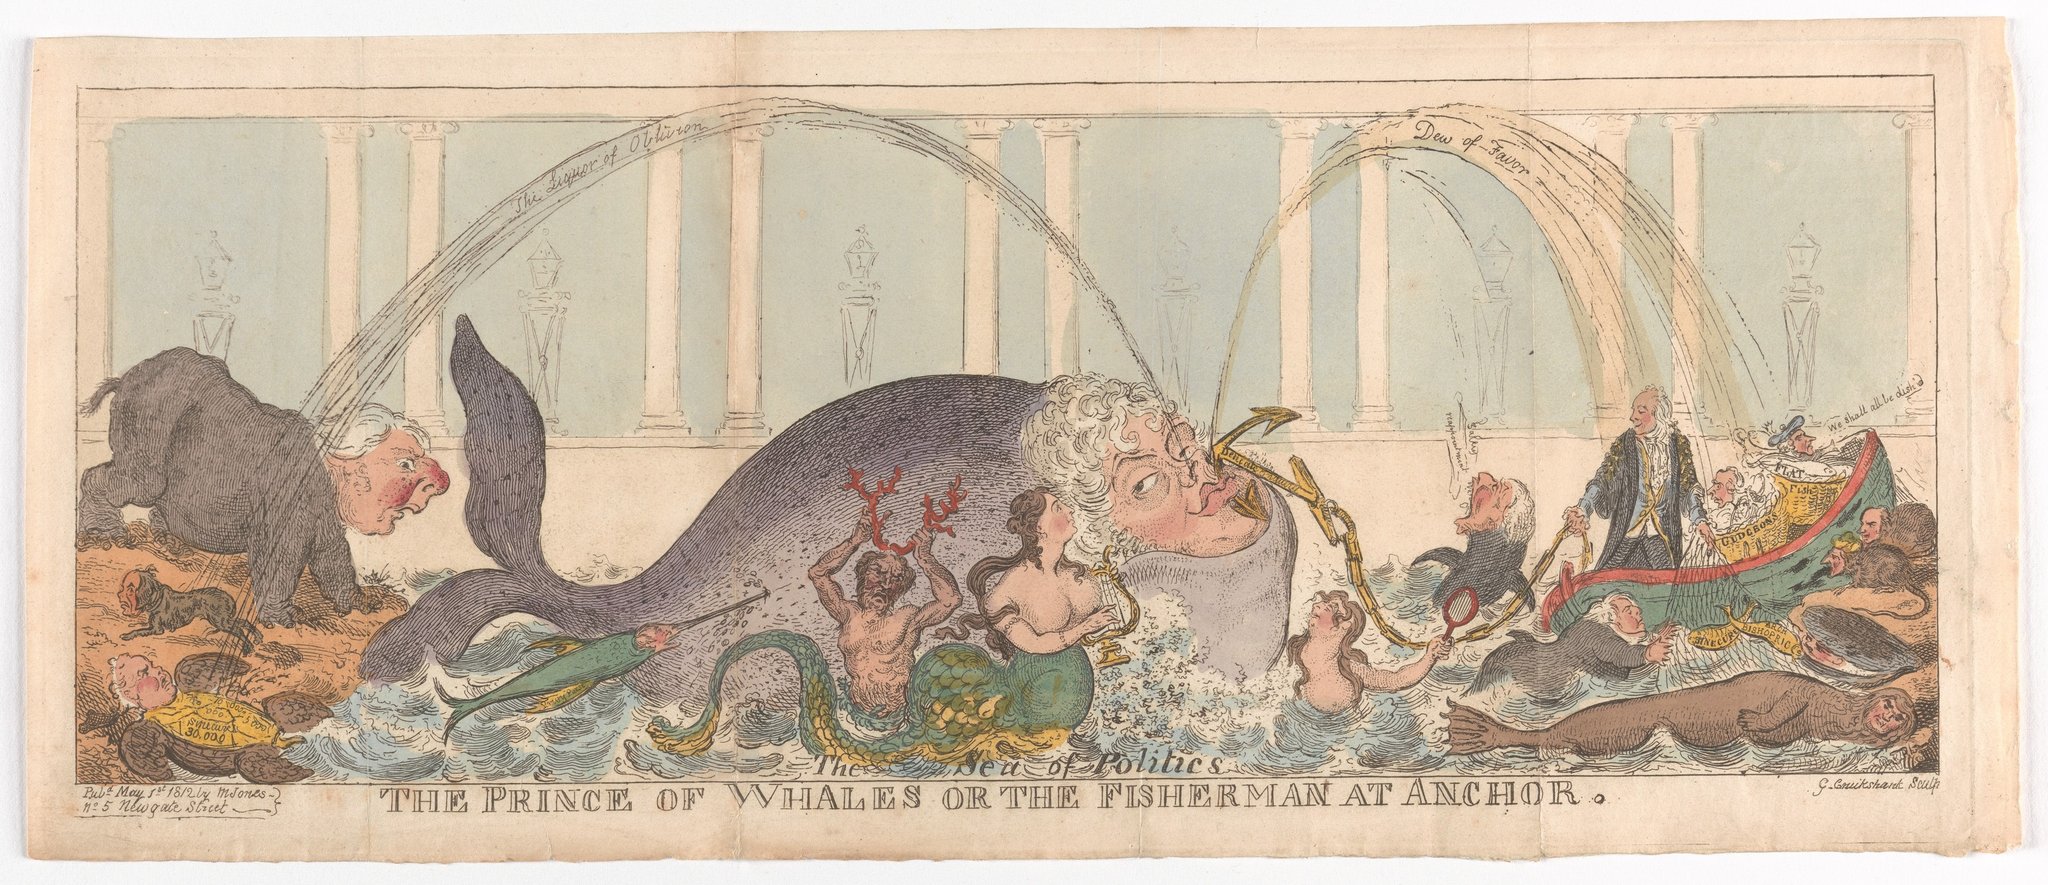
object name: print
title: The Prince of Whales or the Fisherman at Anchor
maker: george cruikshank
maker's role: artist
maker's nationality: british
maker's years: 1792-1878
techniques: etching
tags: satire,mermaids,fish